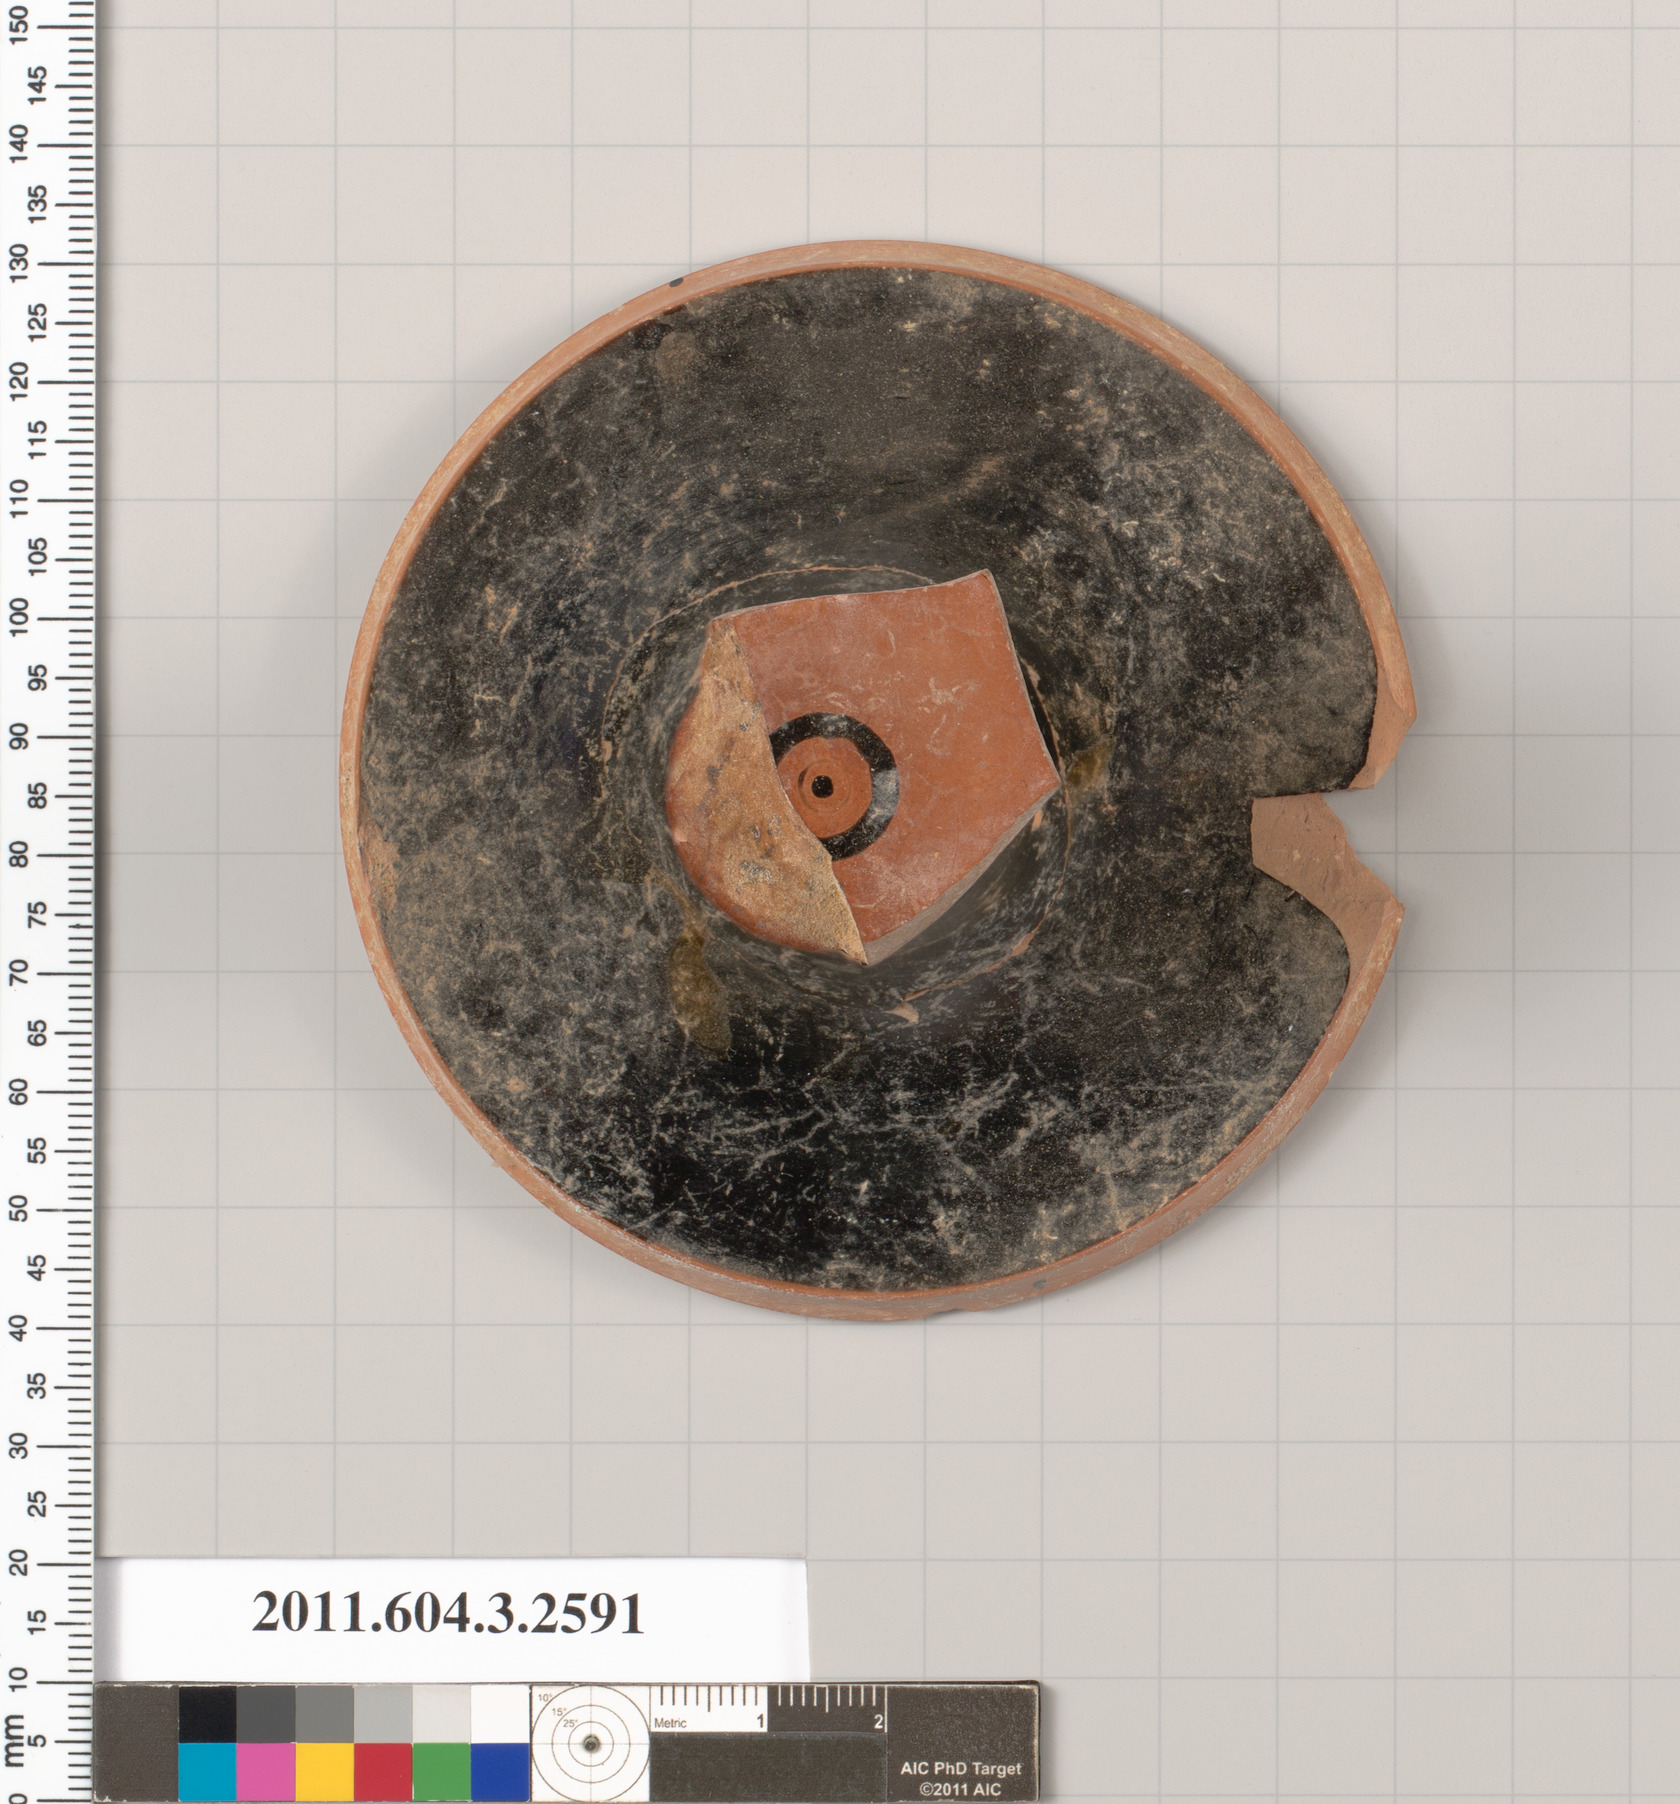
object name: kylix fragment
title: Terracotta fragment of a kylix (drinking cup)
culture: greek, attic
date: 575-525 BCE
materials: terracotta